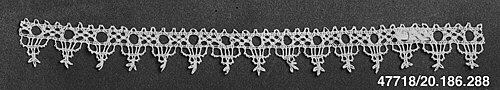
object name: edging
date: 1501-1600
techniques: lace